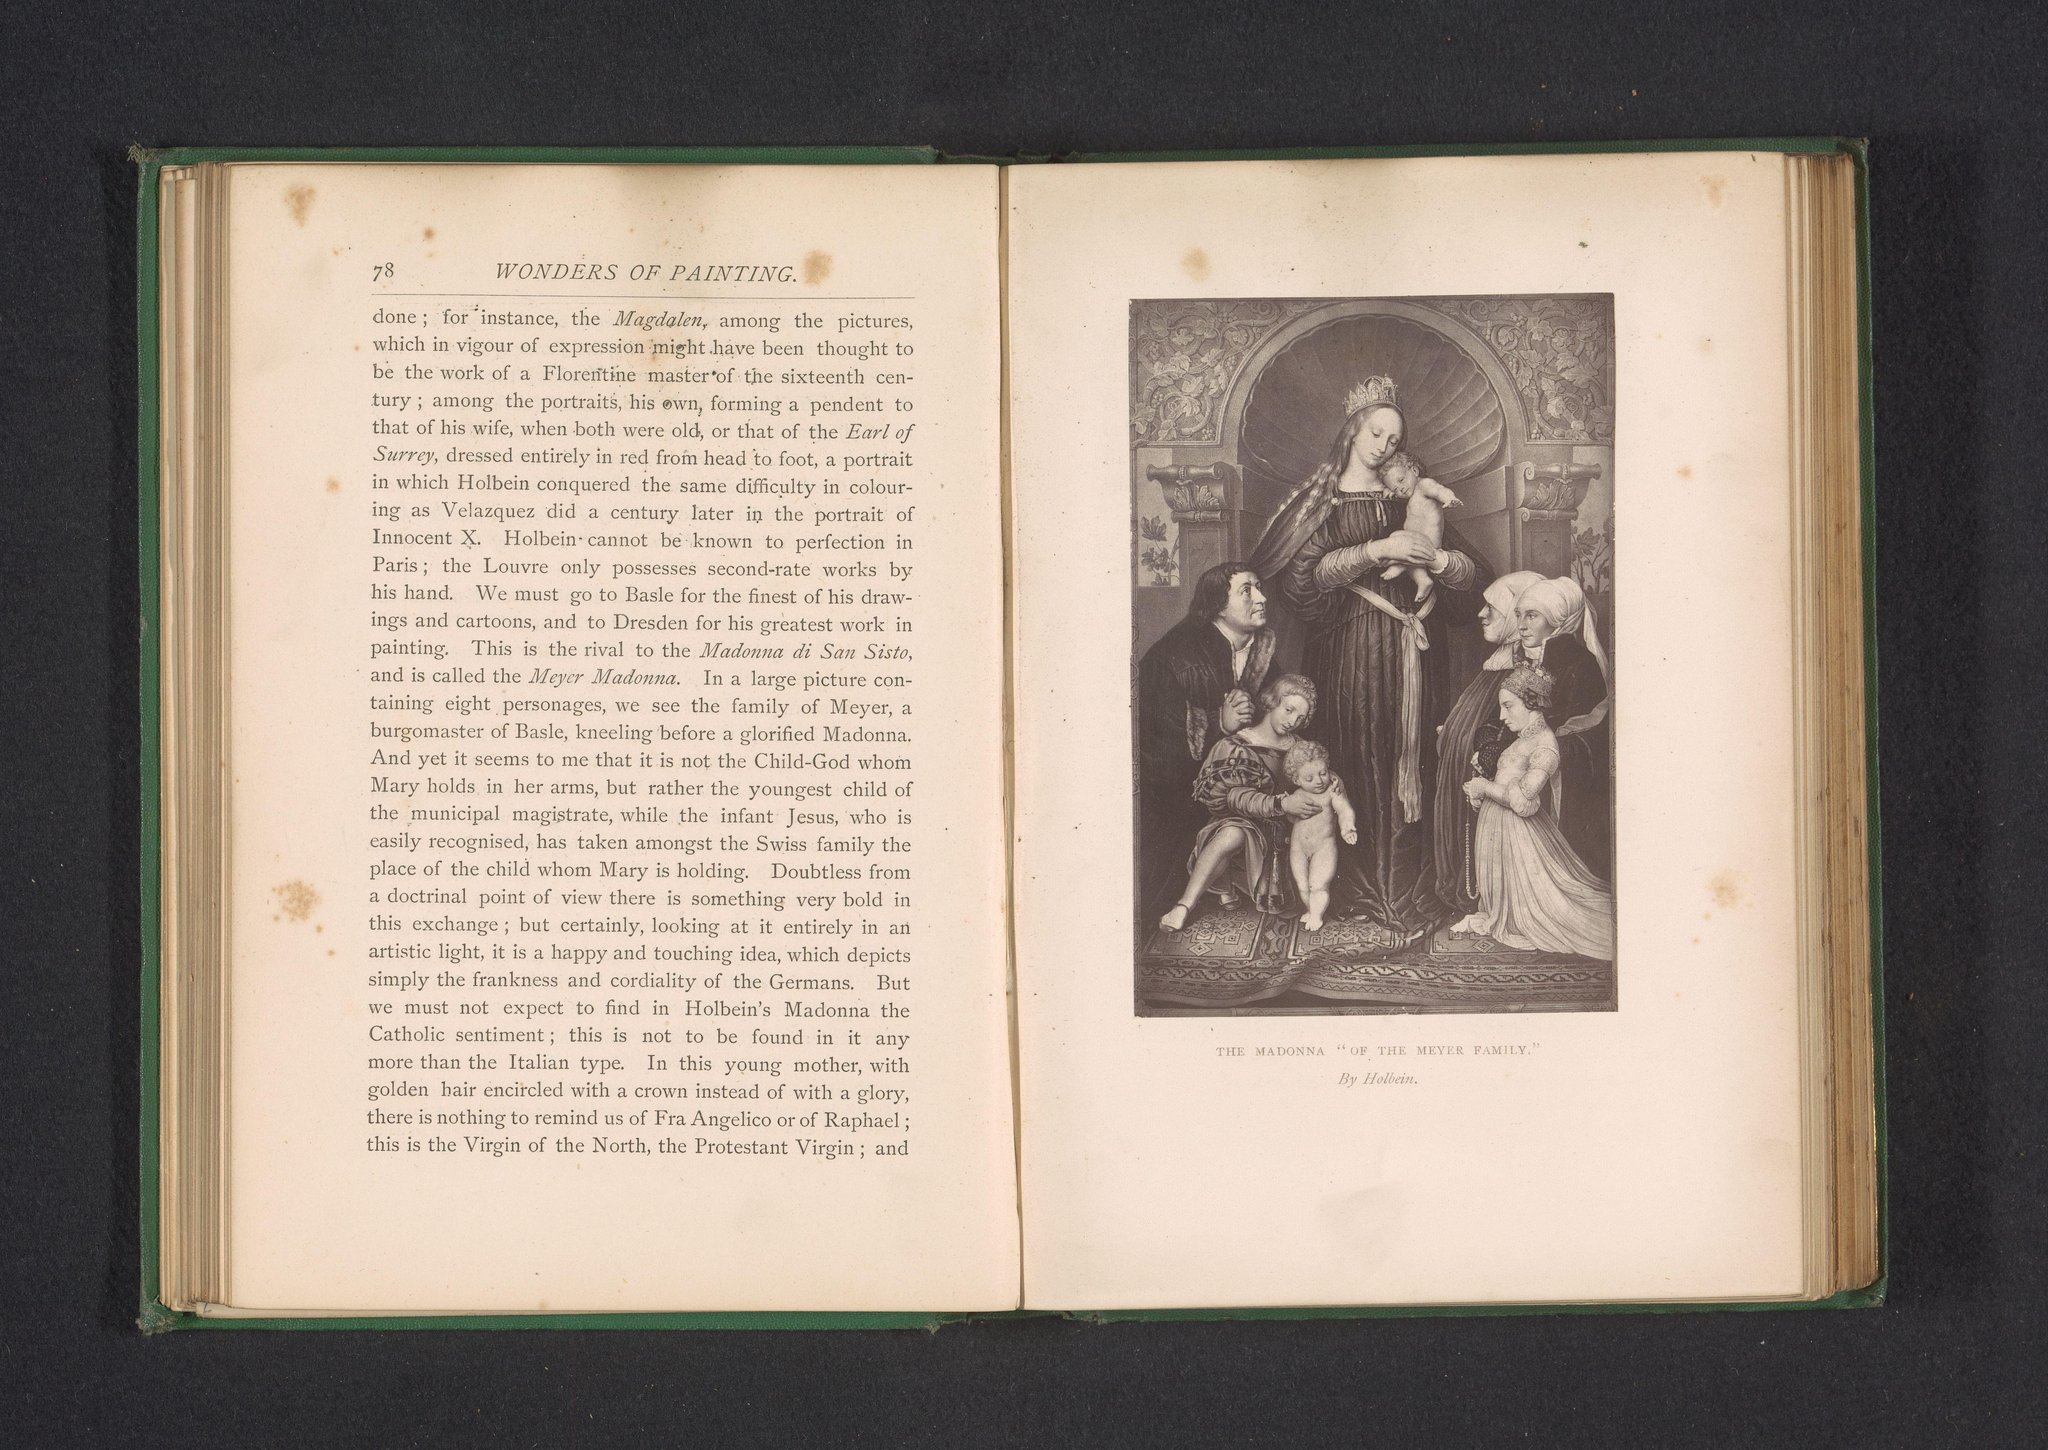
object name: reproduction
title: The Madonna “of the Meyer family.” By Holbein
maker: Anonymous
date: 1861-1871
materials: paper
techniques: woodburytype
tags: madonna: i.e. mary with the christ-child